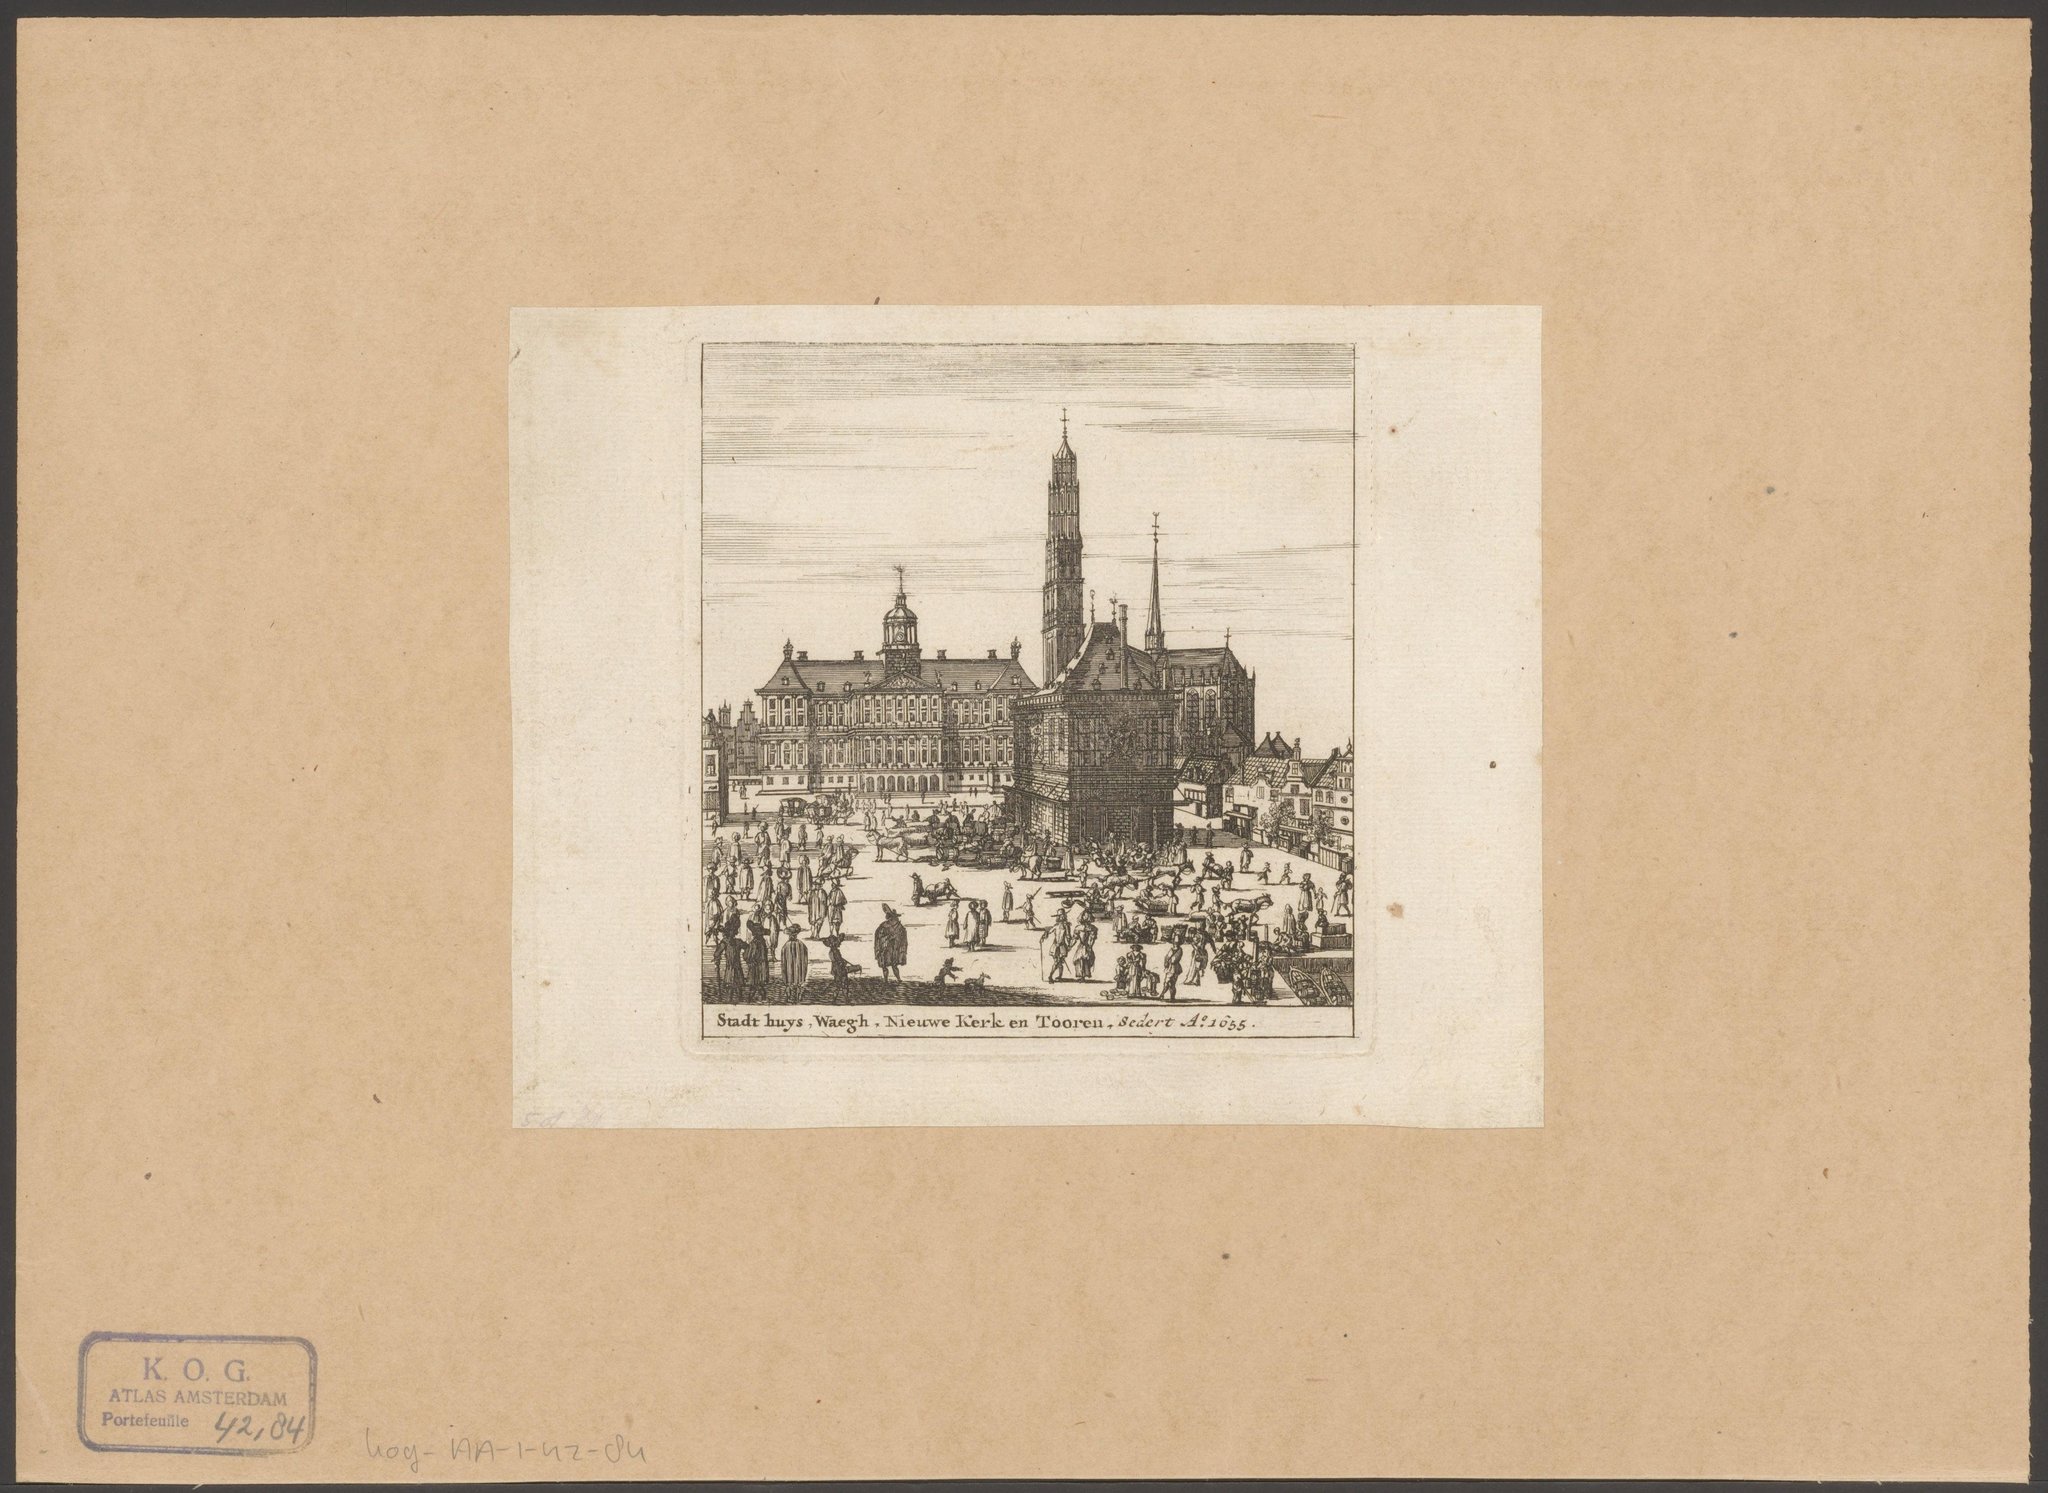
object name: print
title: Stadt huys, Waegh, Nieuwe Kerk en Tooren, Sedert Ao. 1655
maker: Anonymous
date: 1729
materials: paper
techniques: etching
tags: weigh-house, square, place, circus, etc. (+ city(-scape) with figures, staffage), amsterdam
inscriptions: collector's mark: Lugt 1461b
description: Prent mogelijk uit: Long, Isaac le. Historische beschryvinge van de Reformatie der stadt Amsterdam. Amsterdam: Johannes van Septeren I, 1729.